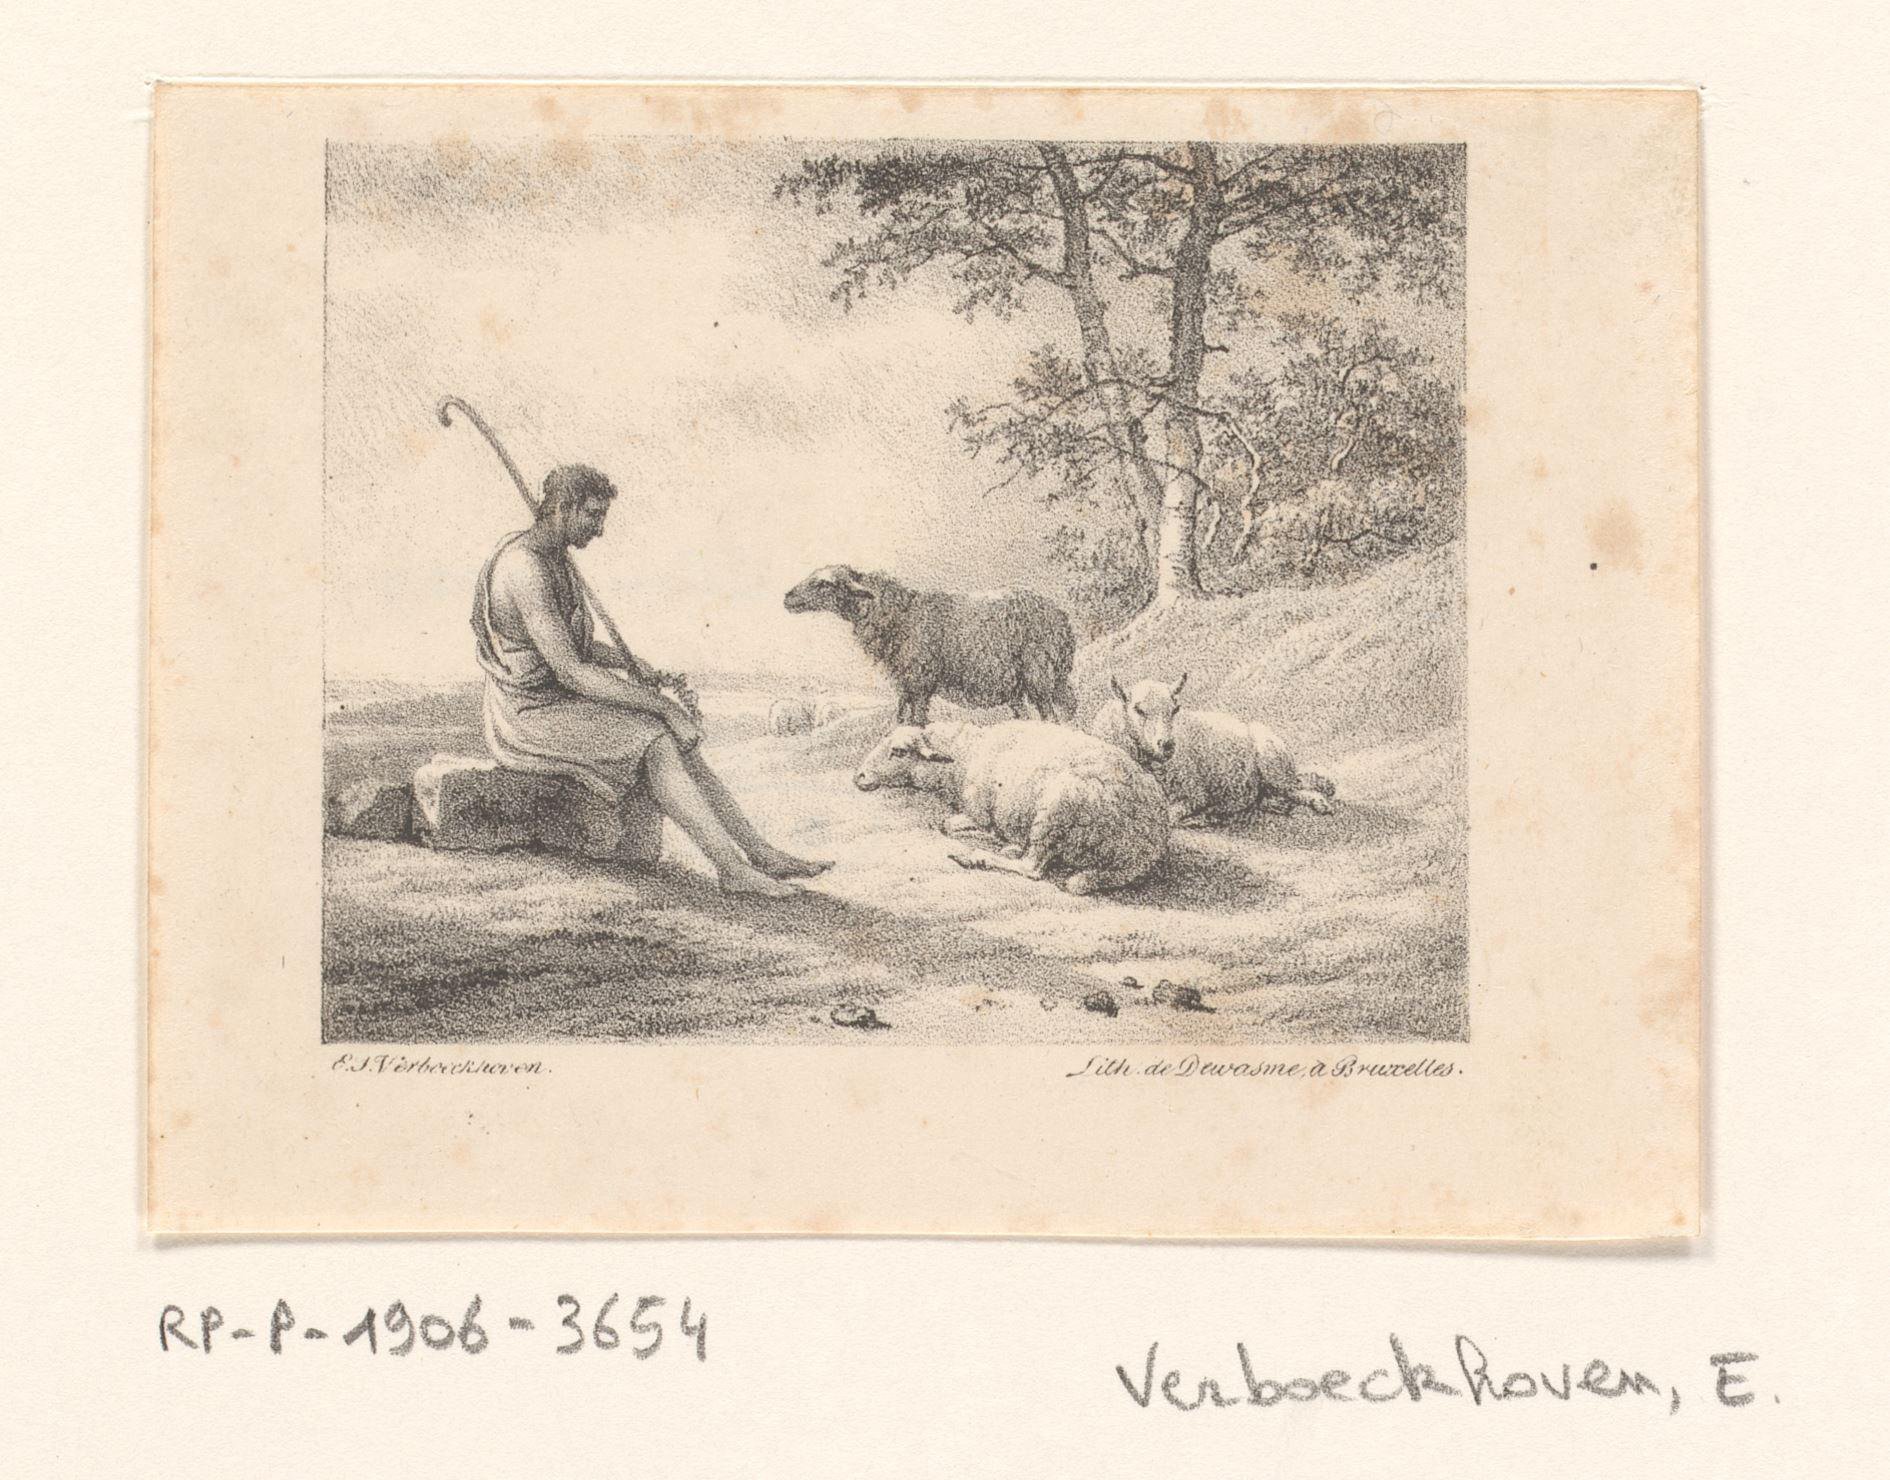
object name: print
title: Rustende herder met schapen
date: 1827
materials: paper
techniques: lithograph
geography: brussels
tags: pastorals, arcadian scenes, herd, flock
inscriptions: collector's mark: Lugt 2228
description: Prent waarschijnlijk uit: Belgische Muzen-Almanak, jaargang 2, 1827.